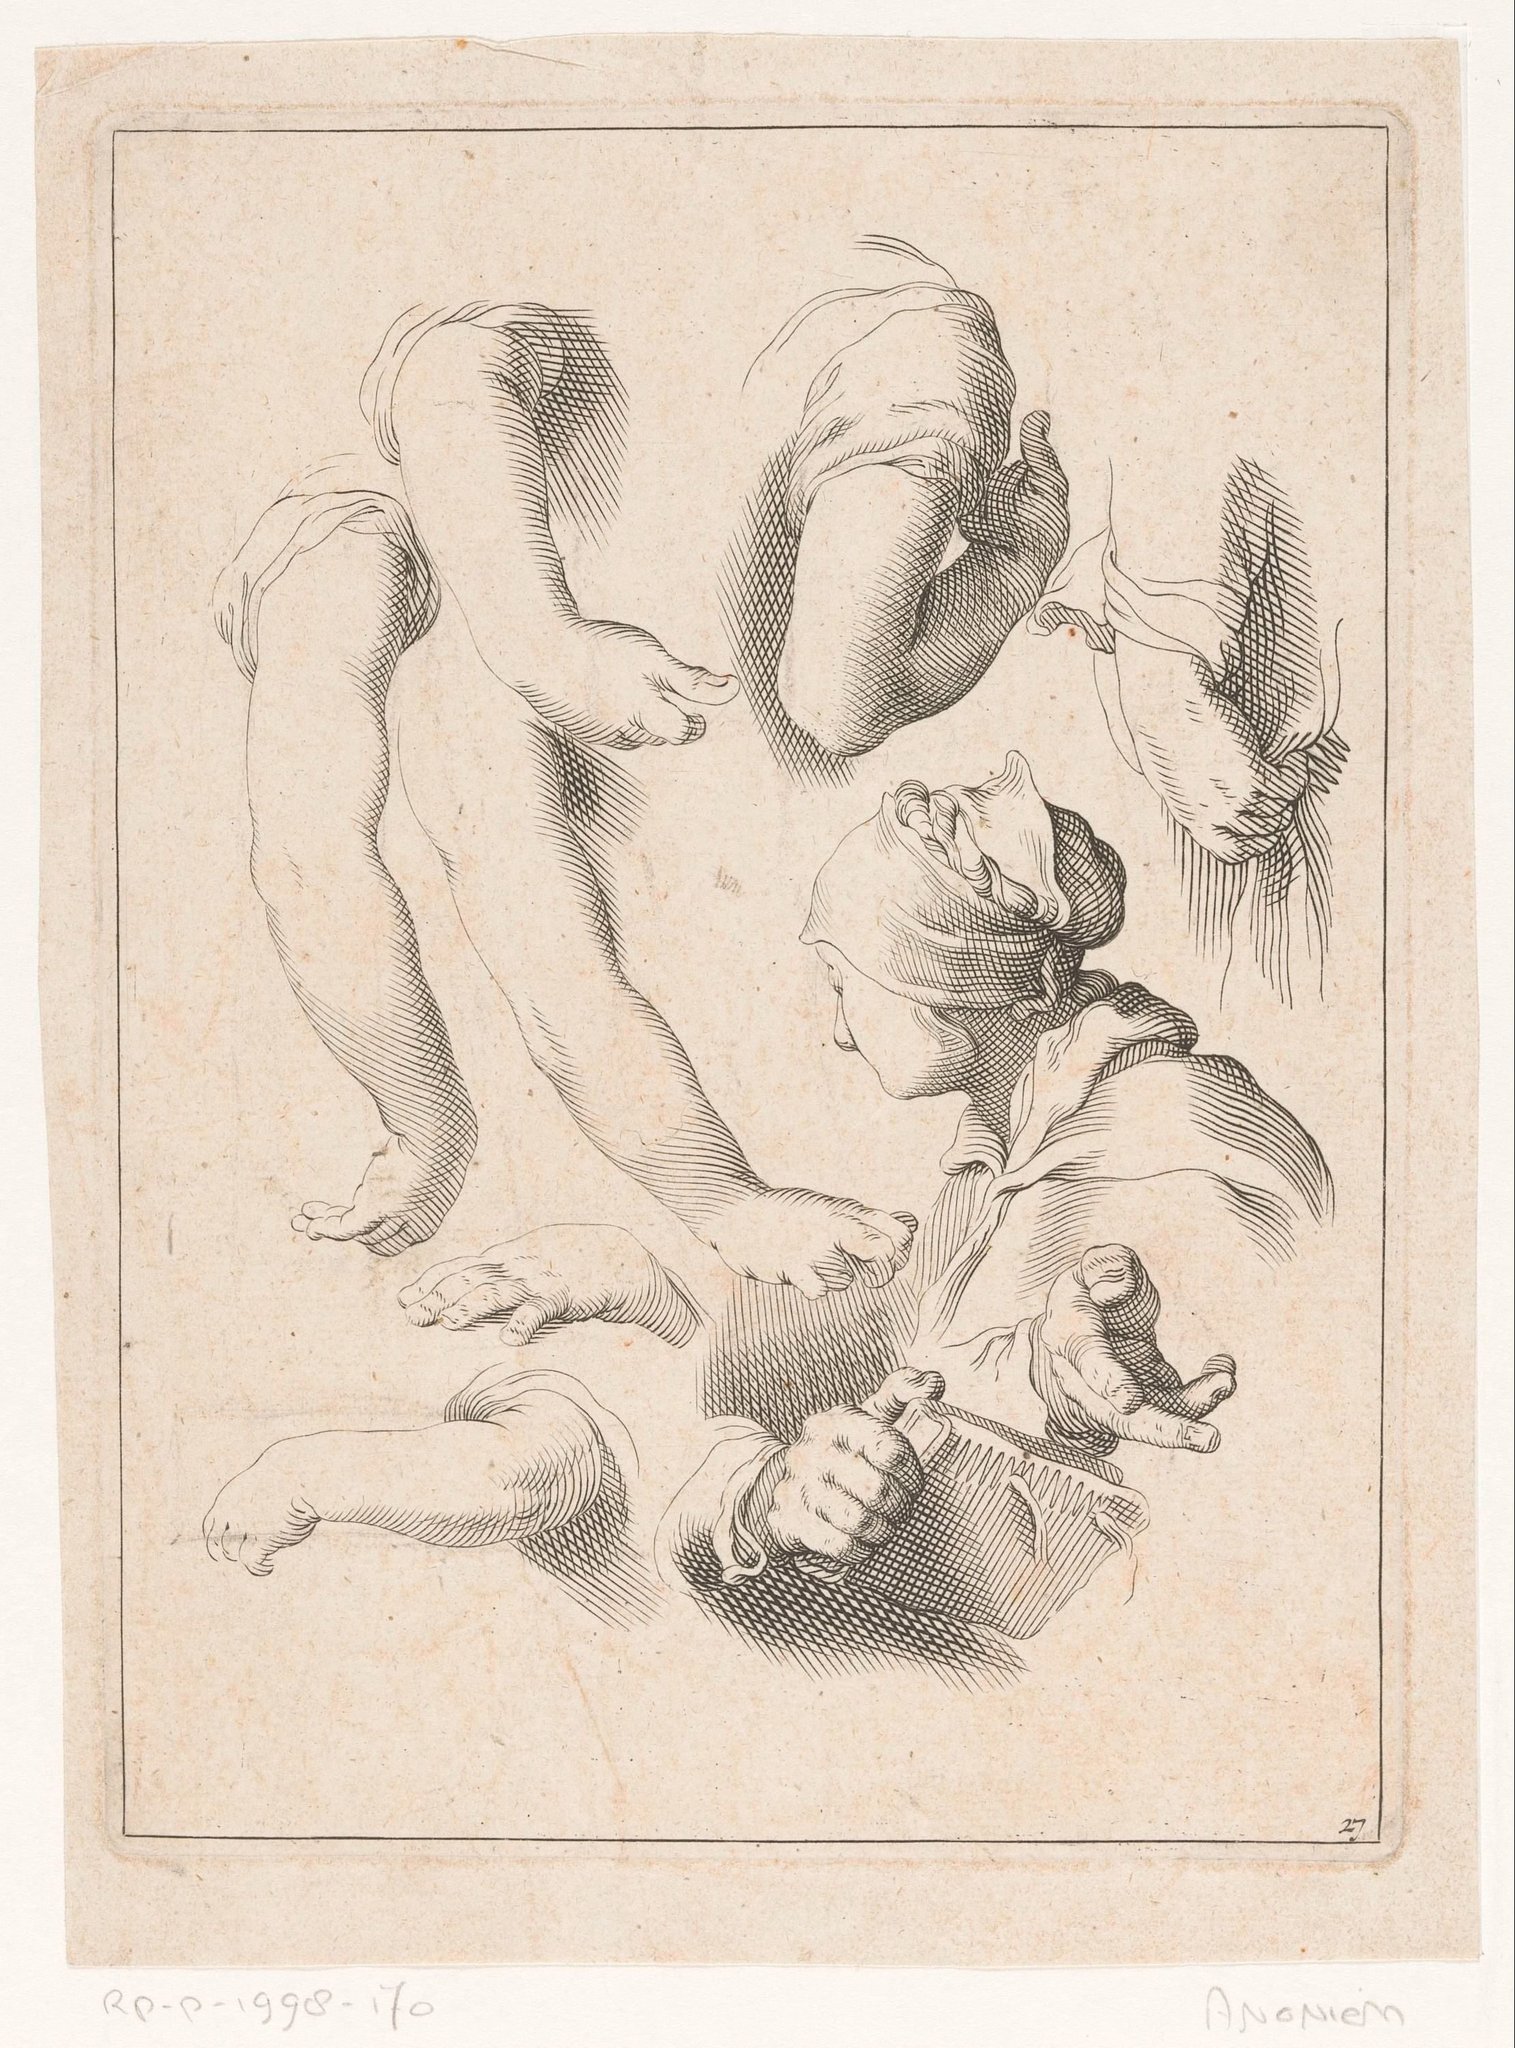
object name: print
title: Armen en vrouwenhoofd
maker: Anonymous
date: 1600-1699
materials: paper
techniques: engraving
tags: the (nude) human figure; 'corpo humano' (ripa)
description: Armen, handen en een vrouwenhoofd van de achterzijde gezien. Rechts onder 27 genummerd.